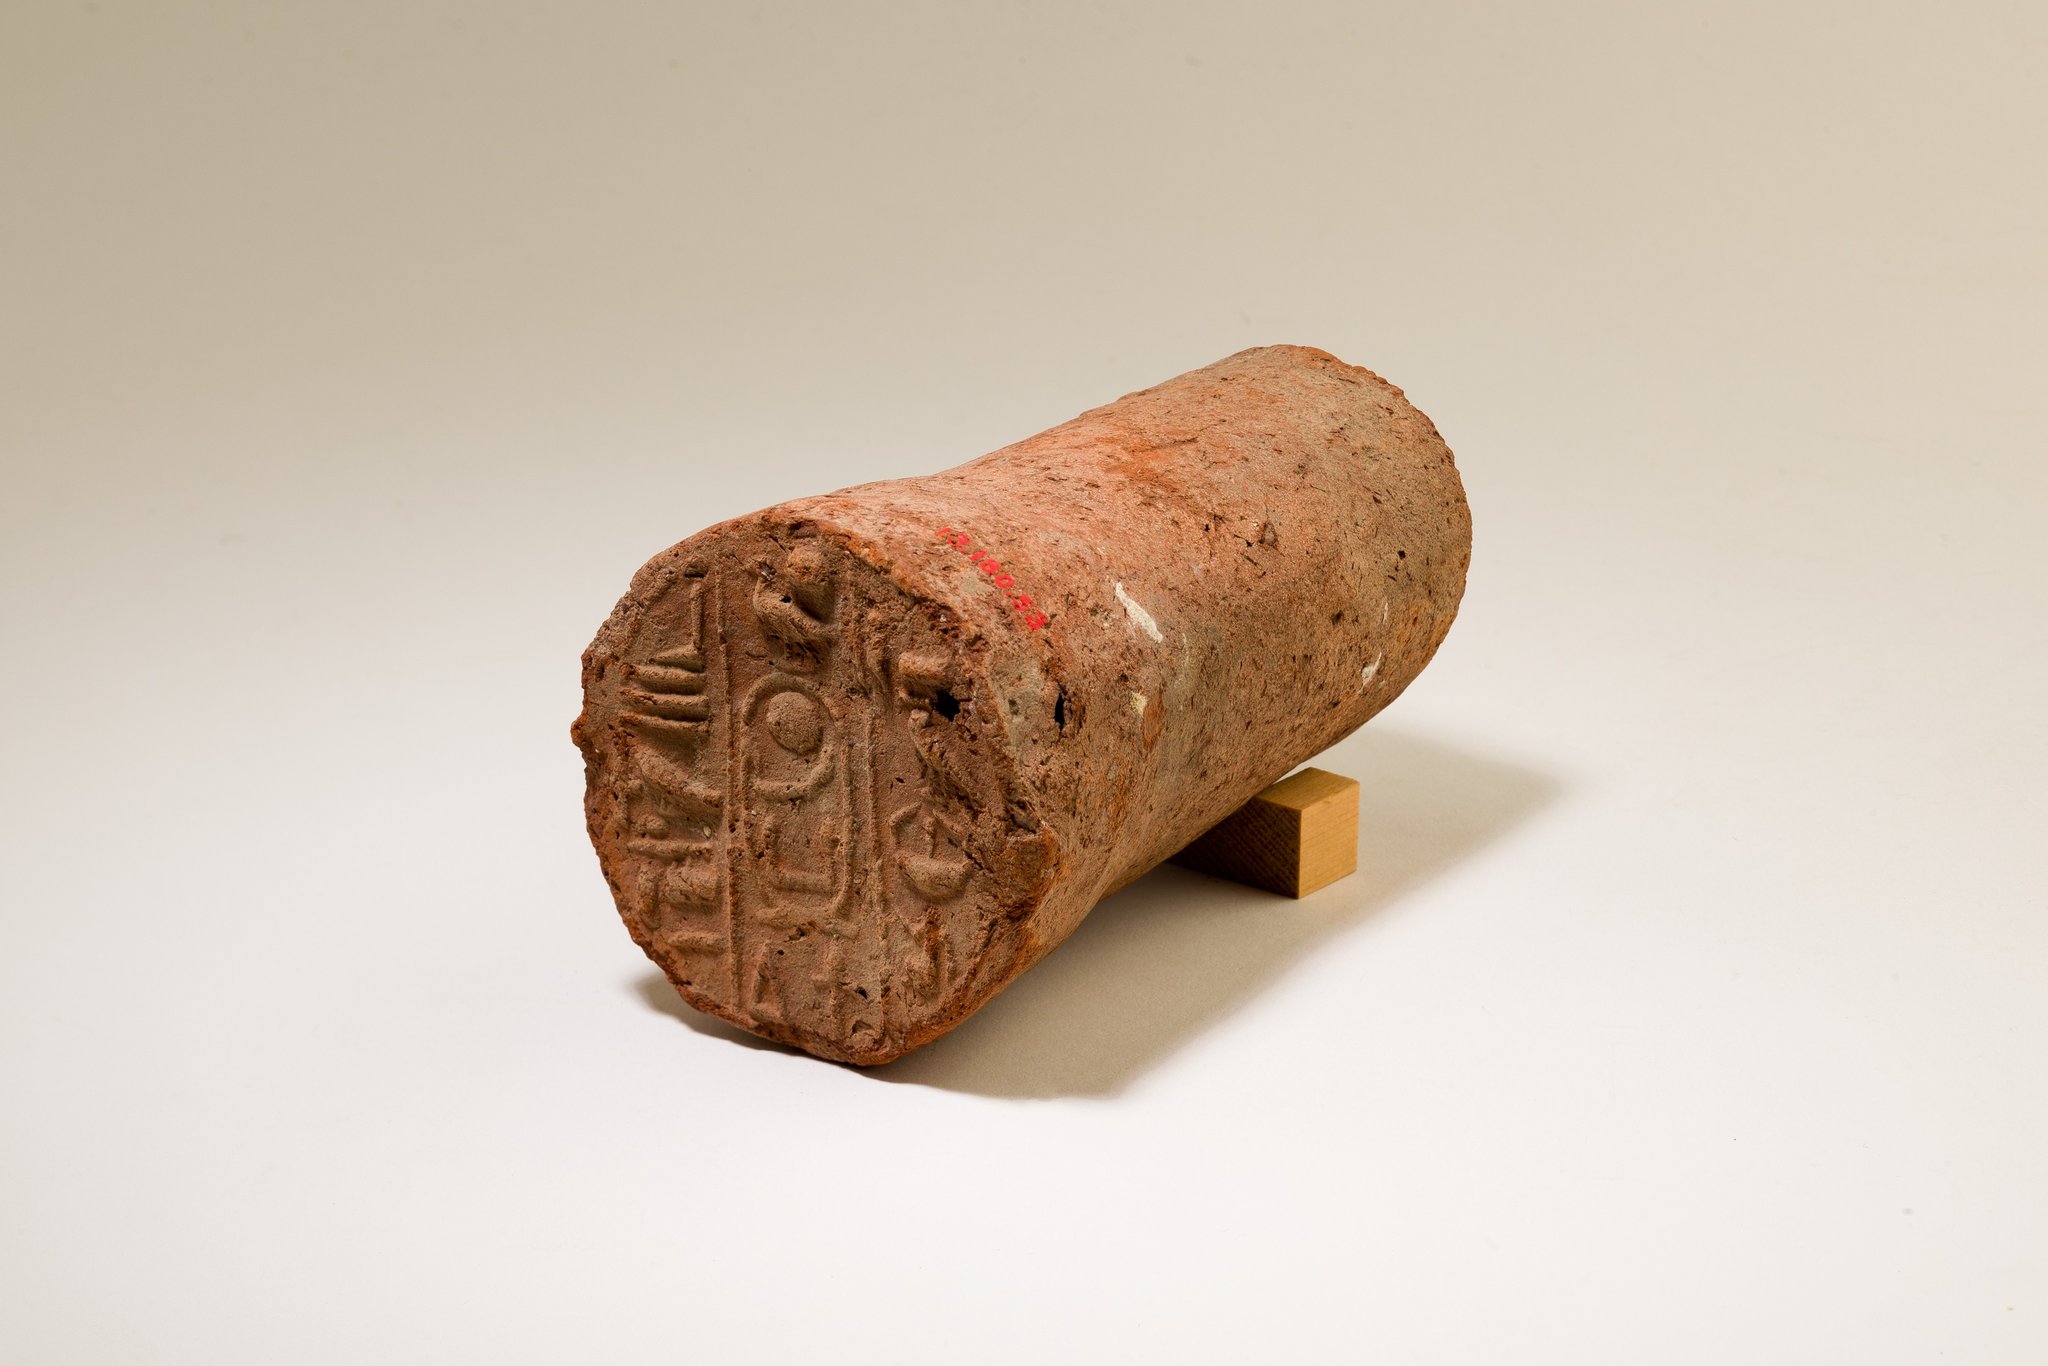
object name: cone, circular impression, amenemhab, wab priest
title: Funerary Cone of the Wab-Priest Amenemhab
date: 1525-1504 BCE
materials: pottery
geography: egypt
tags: hieroglyphs